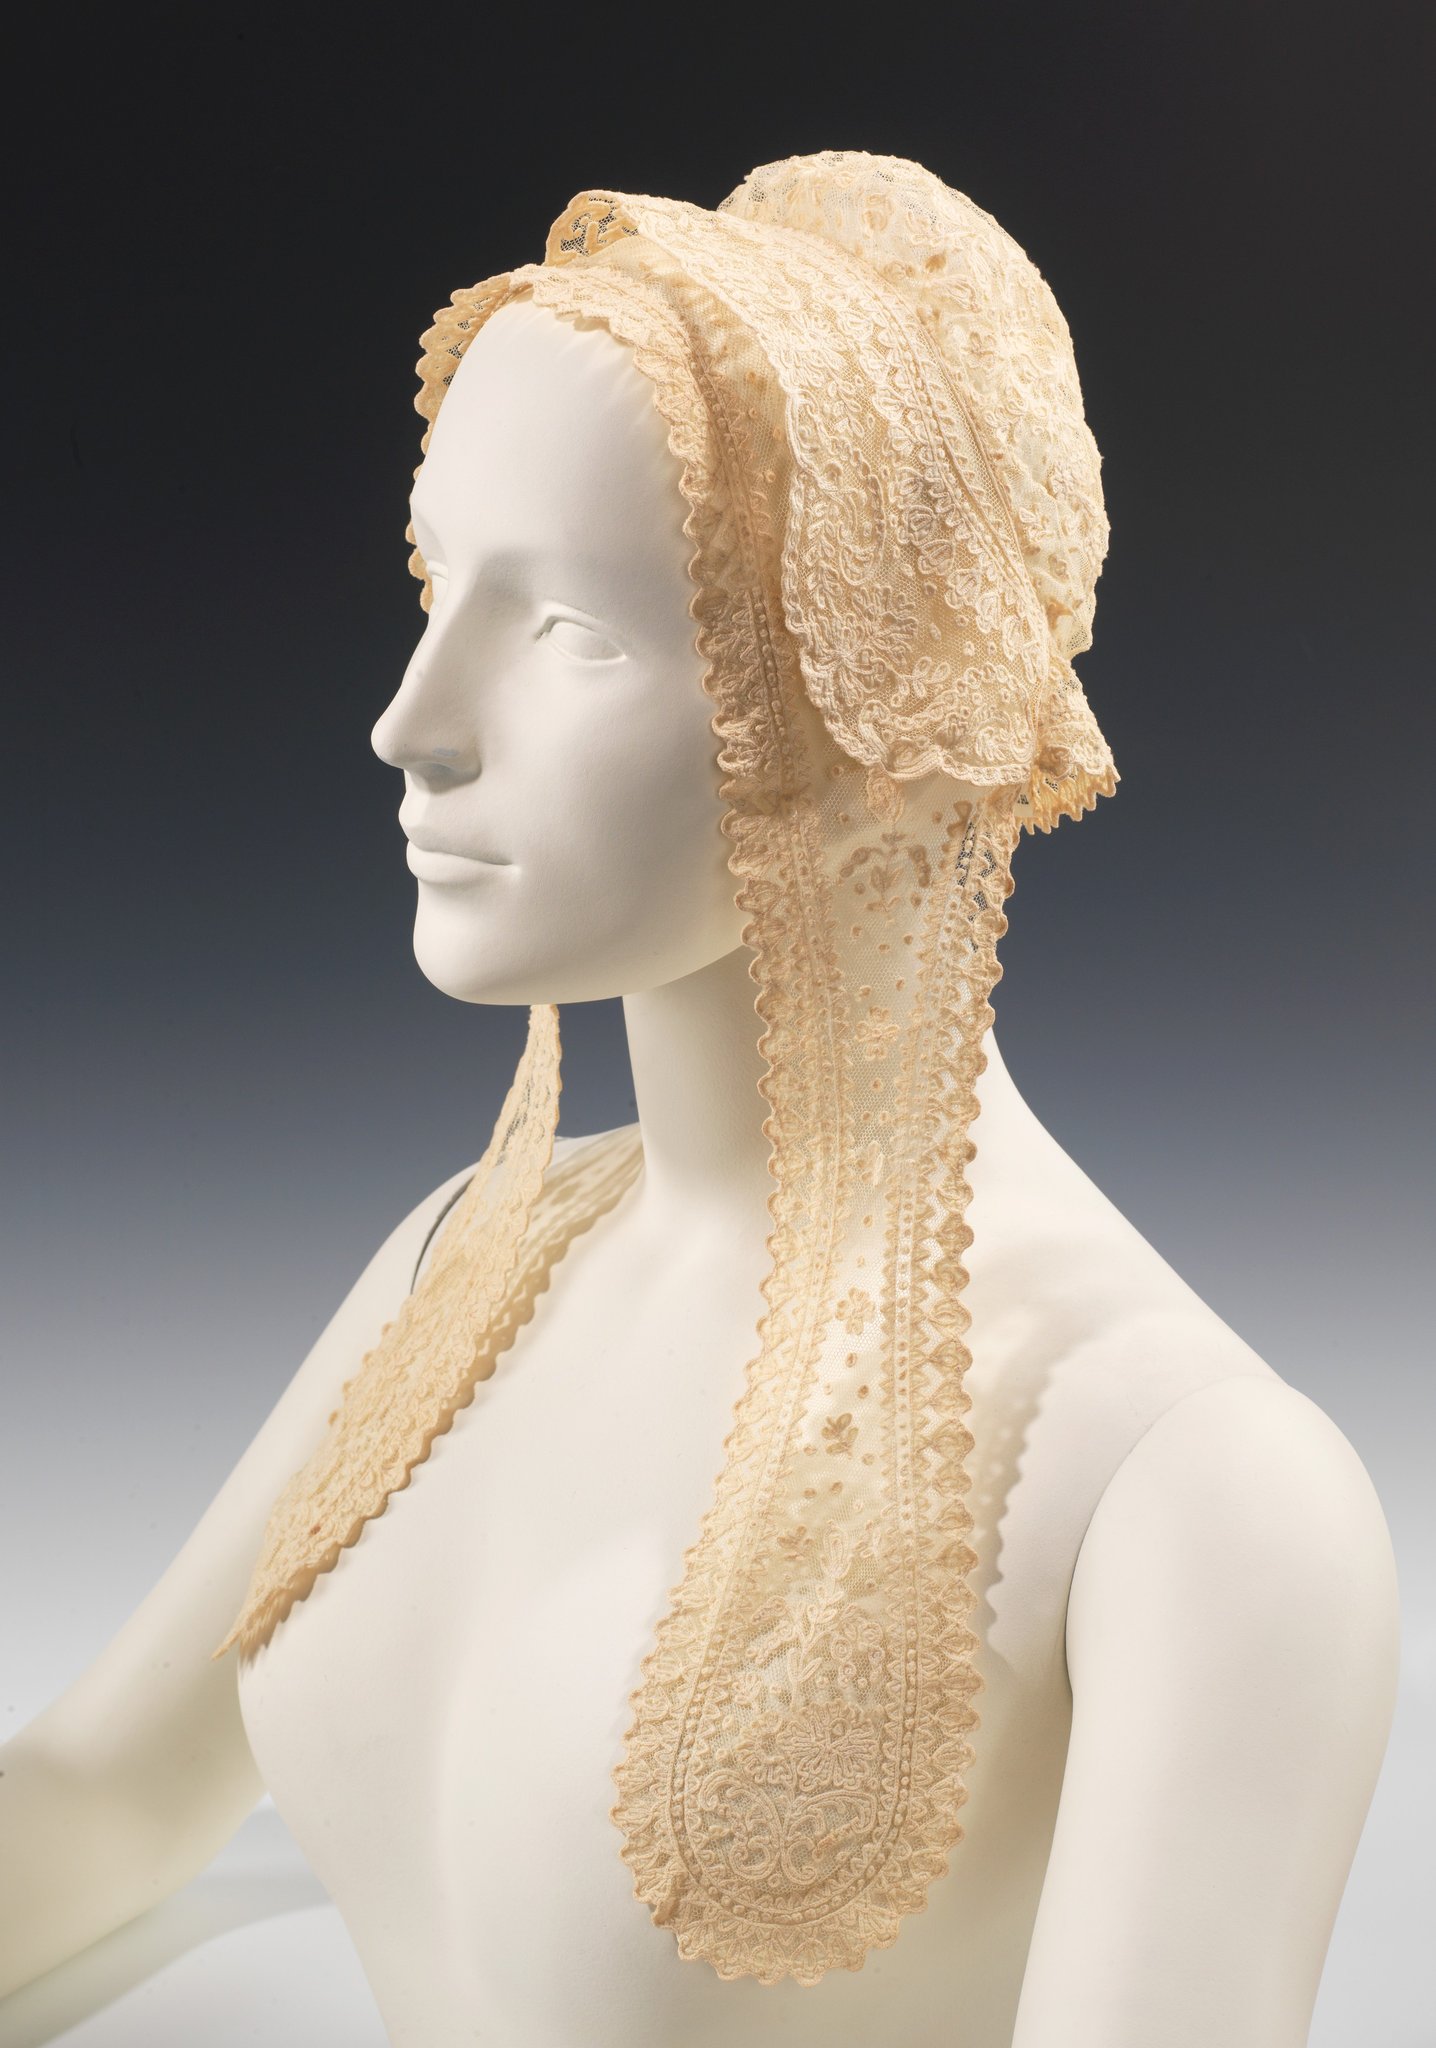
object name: cap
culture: irish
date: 1870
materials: cotton, linen